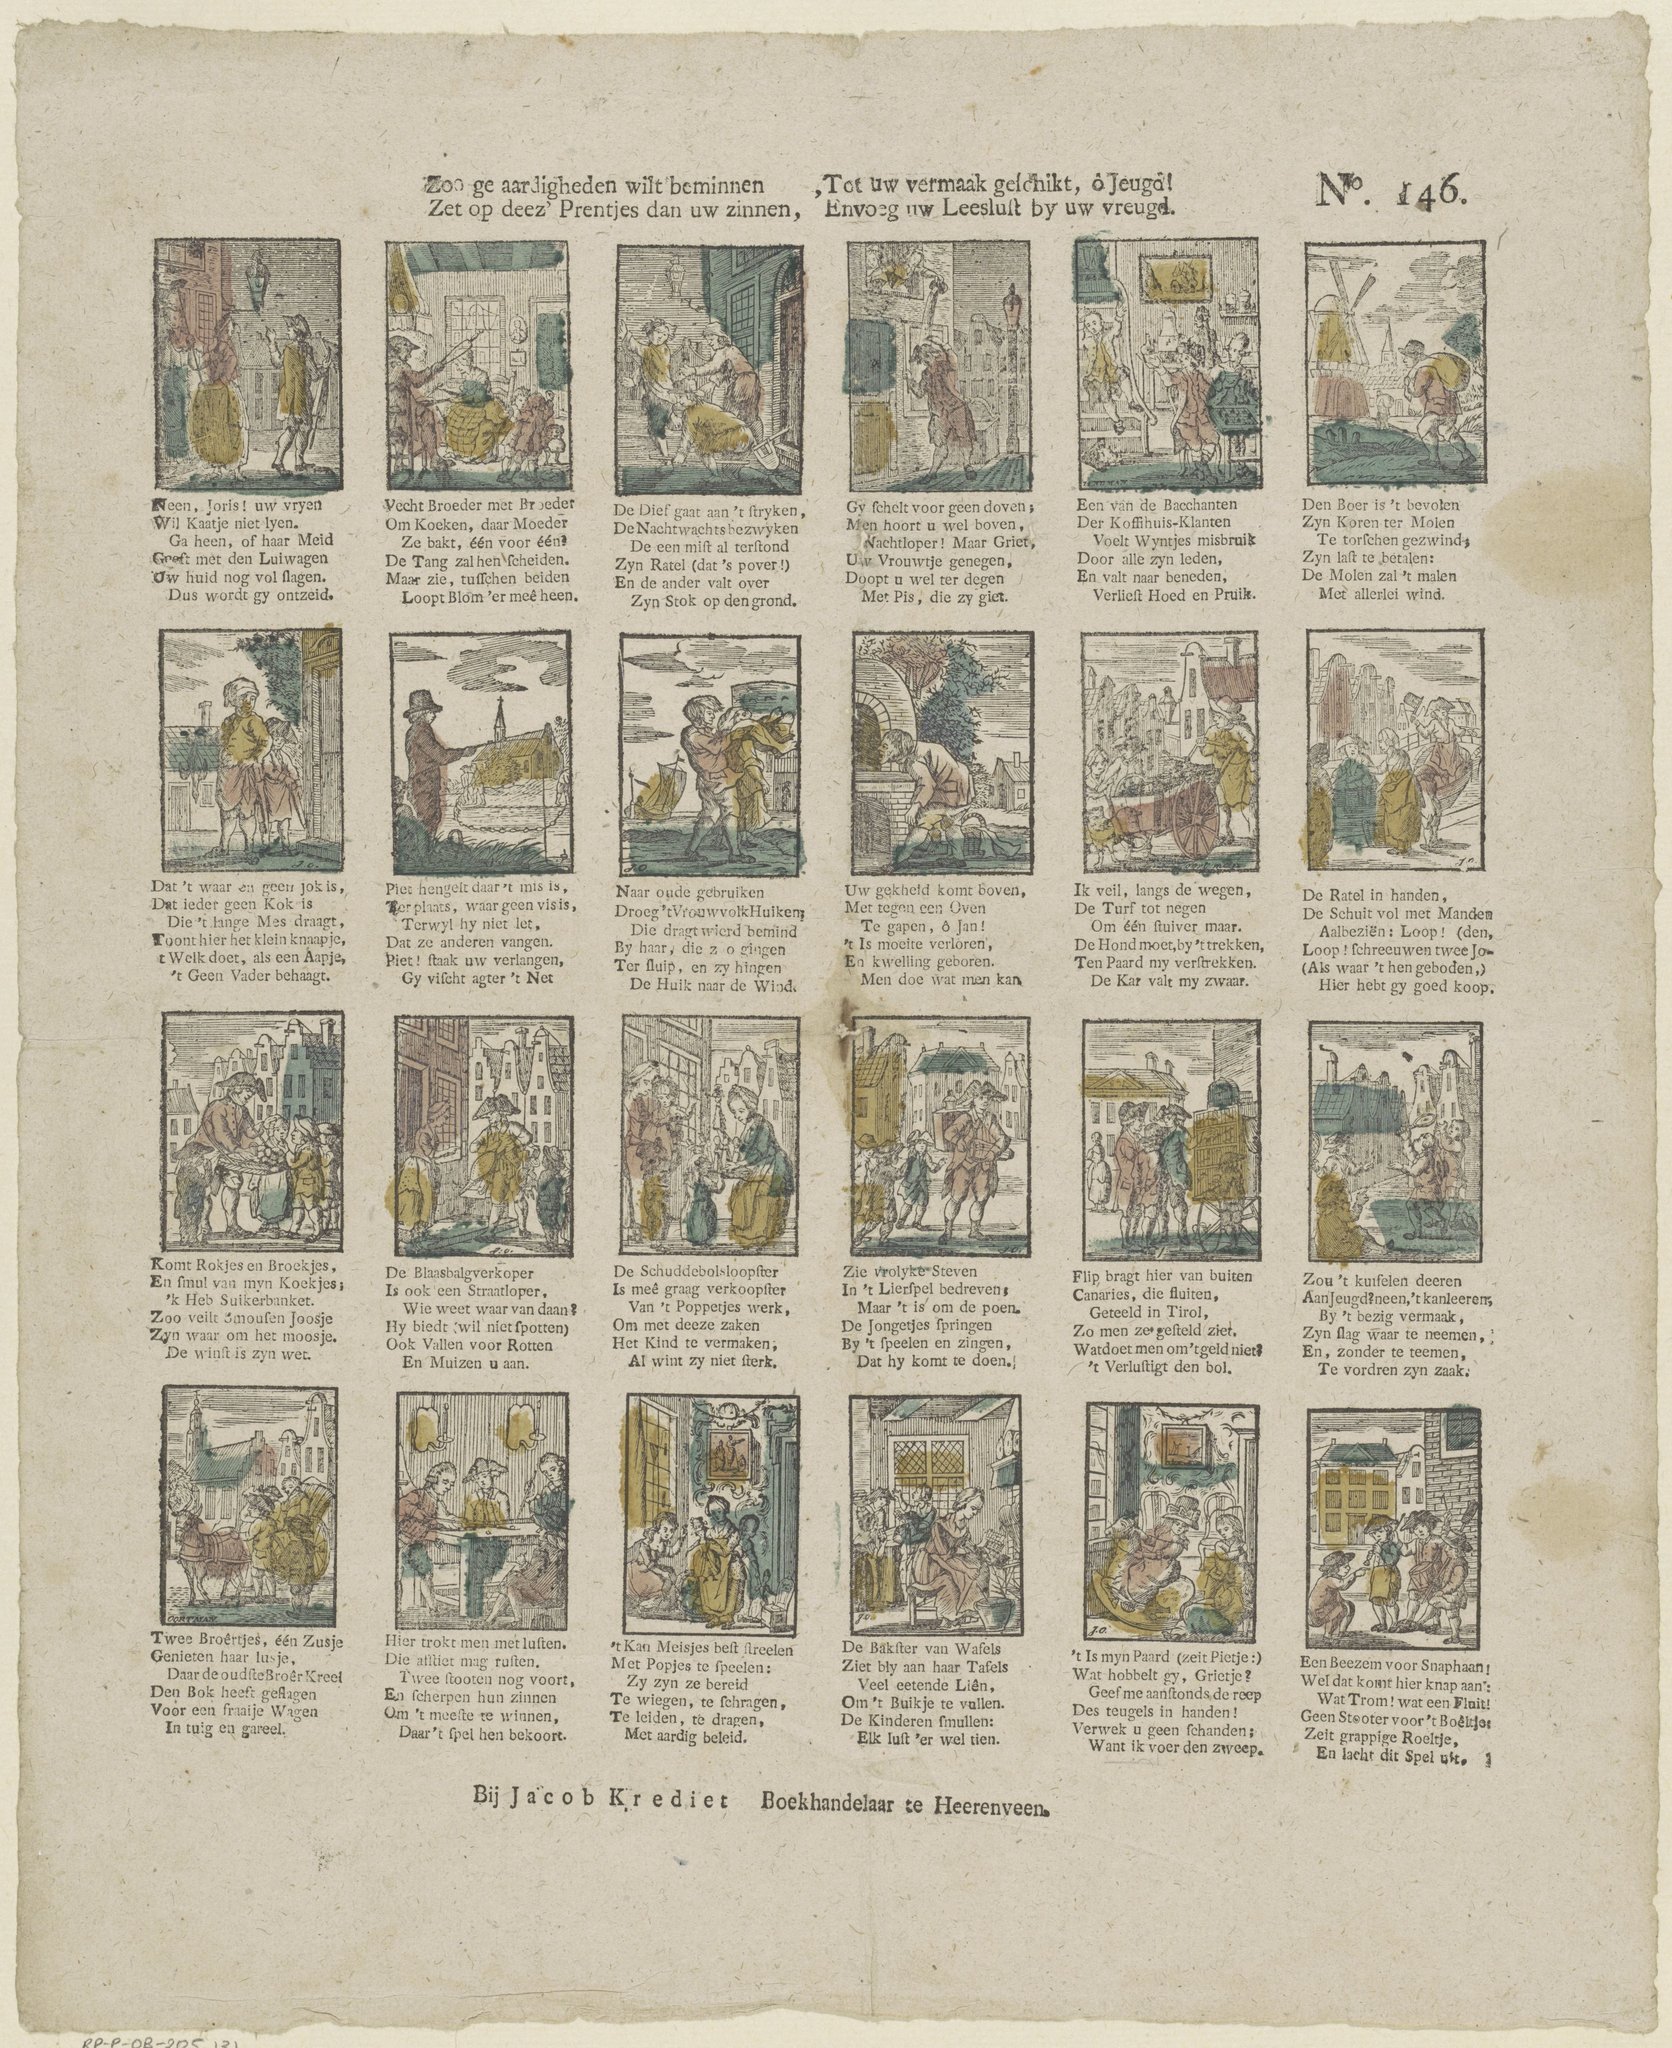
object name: popular print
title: Zo ge aartigheden wilt beminnen, / Zet op deez' prentjes dan uw zinnen, / Tot uw vermaak geschikt, ô jeugd! / Envoeg uw leeslust by uw vreugd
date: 1806-1830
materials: paper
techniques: colour, letterpress printing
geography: heerenveen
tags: human types, farmers, street-trader, (playing with) dolls, fishing (sports)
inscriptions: collector's mark: Lugt 2760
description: Blad met 24 voorstellingen van verschillende figuren en bezigheden. Onder elke afbeelding een zesregelig vers. Genummerd rechtsboven: No. 146.